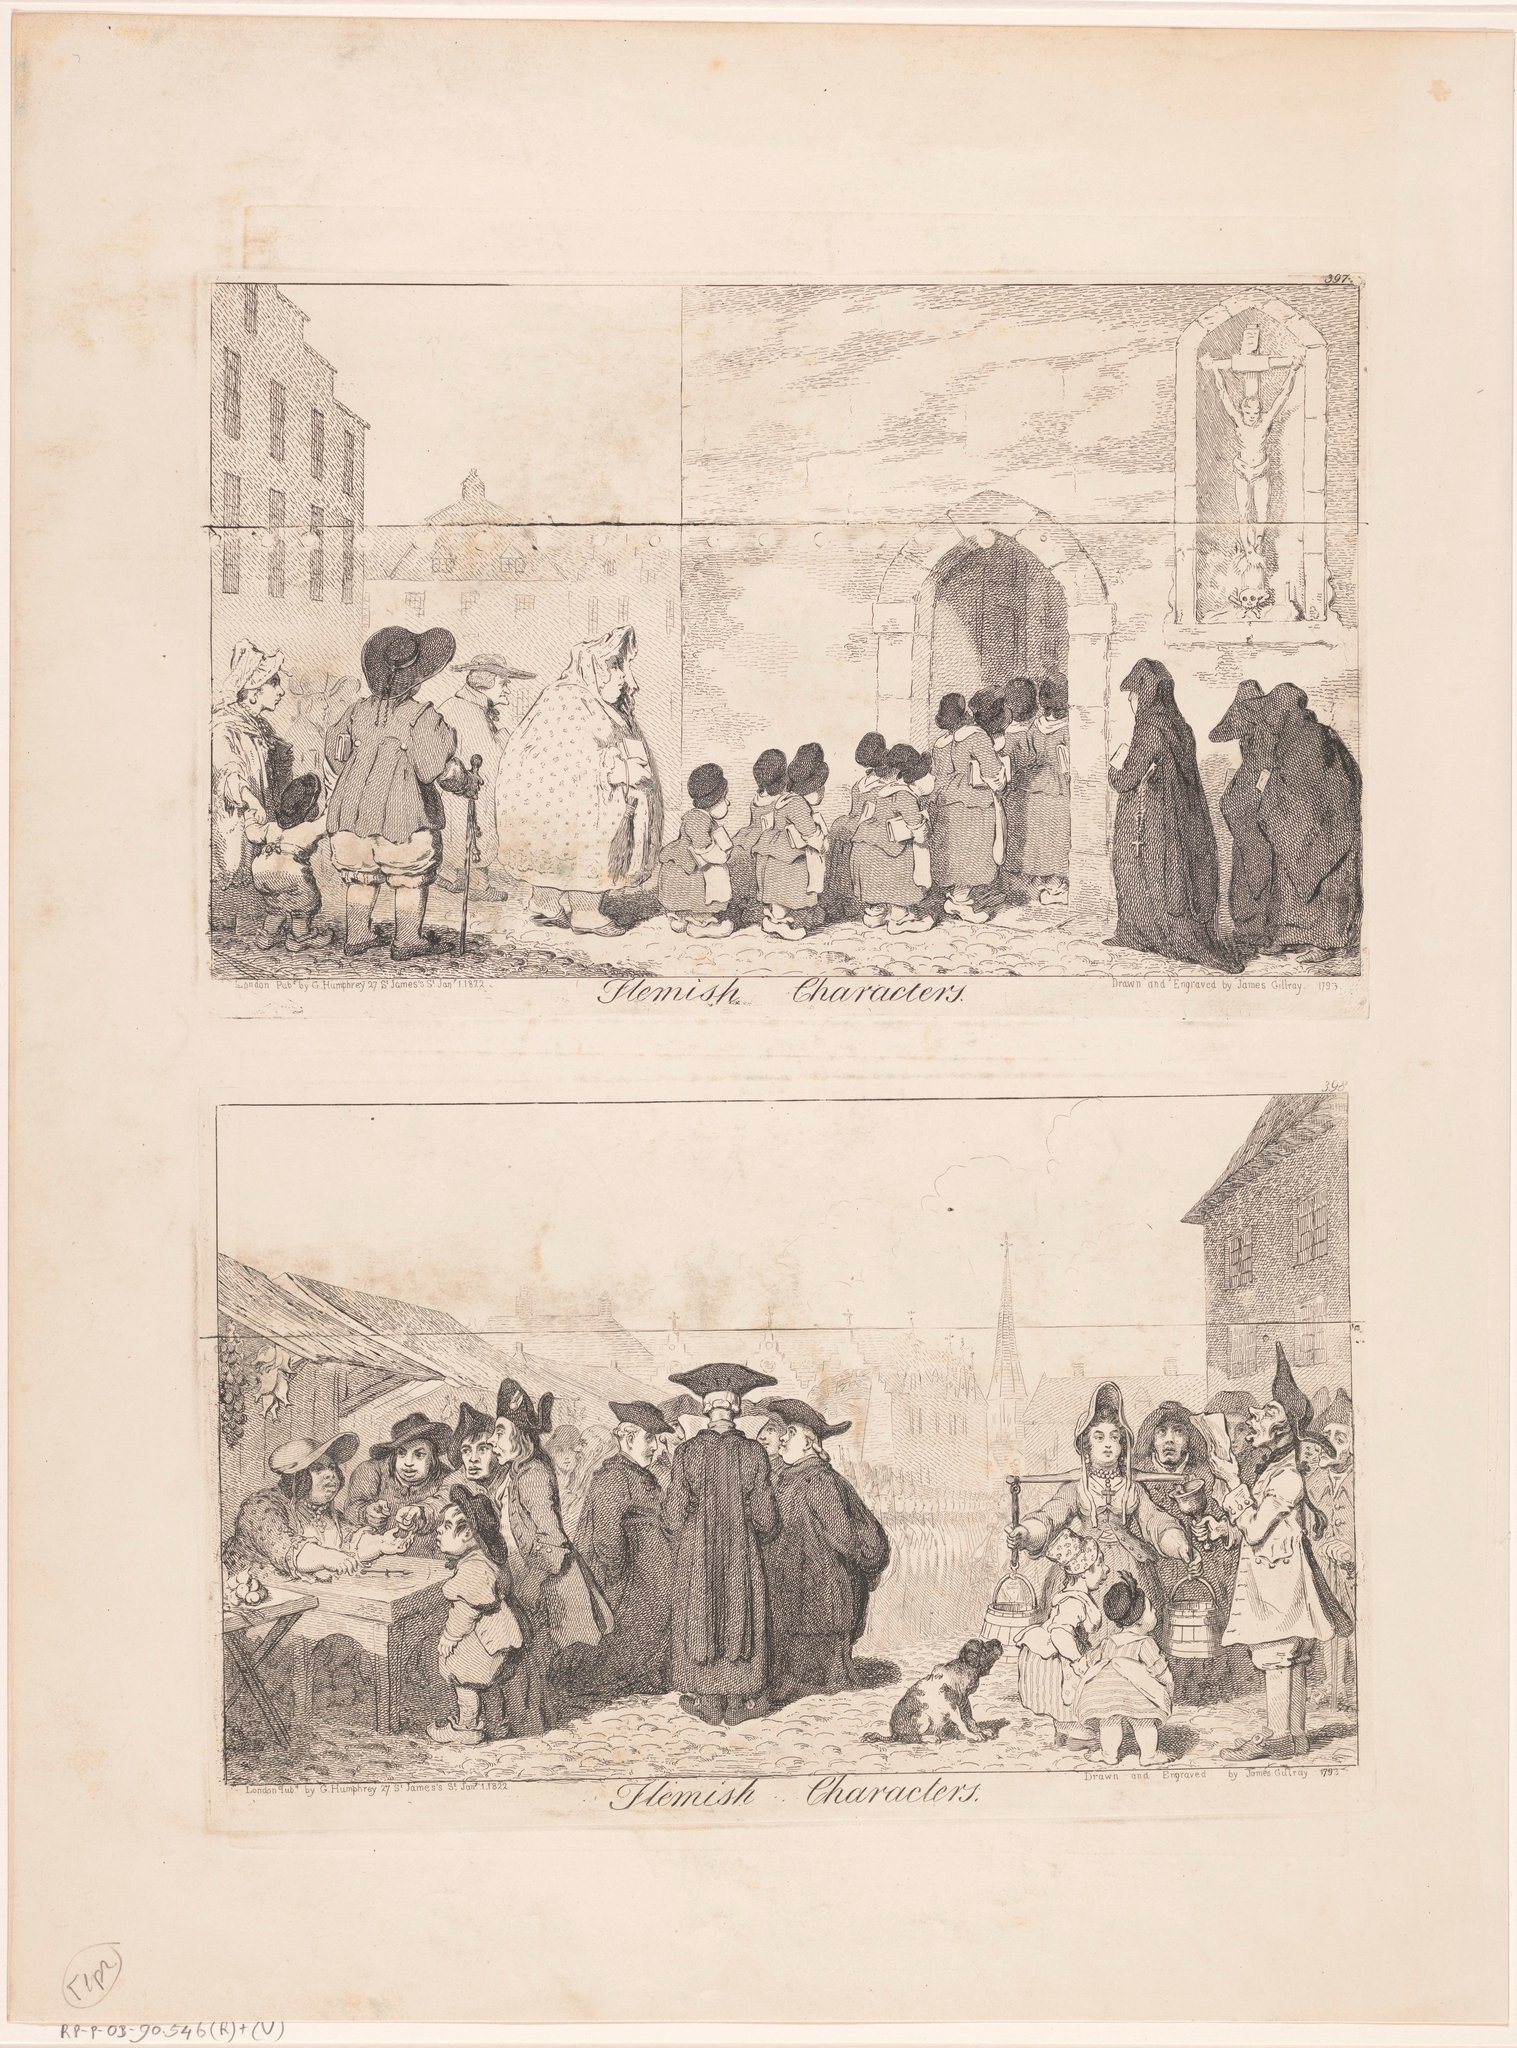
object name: print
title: Flemish Characters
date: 1793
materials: paper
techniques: etching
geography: england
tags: human types, europeans (with name), political caricatures and satires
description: Blad waarop twee platen uit 1793 zijn gedrukt. Twee voorstellingen van Vlaamse of Belgische typen bij de kerkgang (boven) en op de markt (onder). De bovenste plaat genummerd 397, de onderste 398.